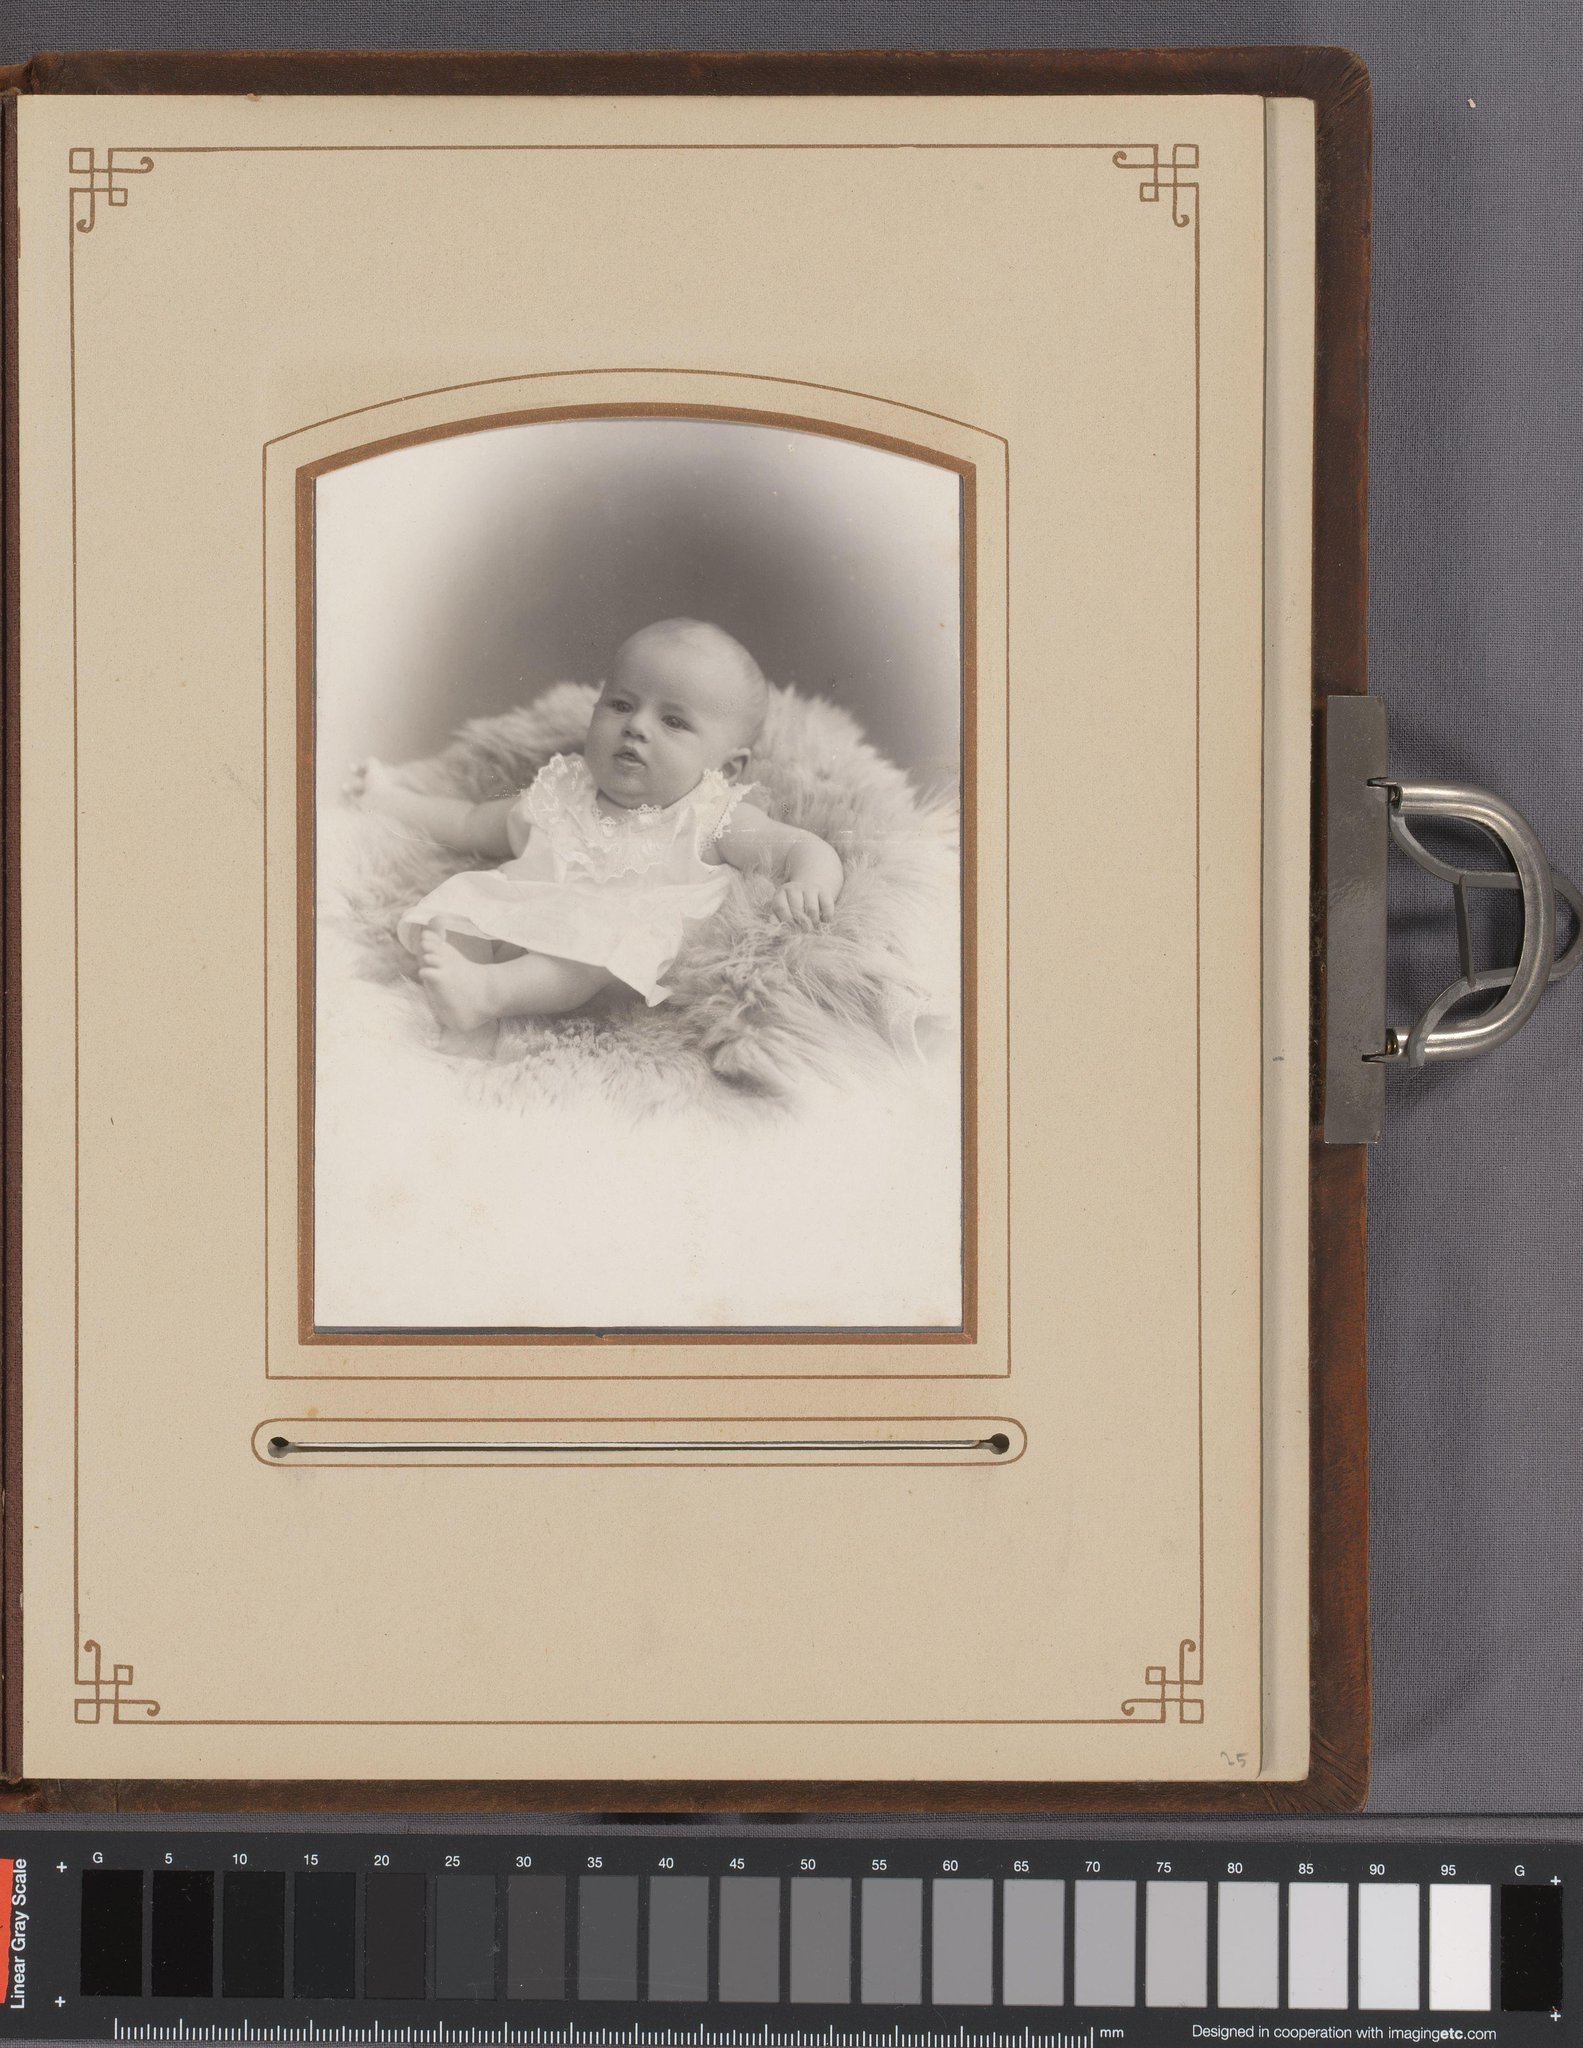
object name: photograph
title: Portret van een baby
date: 1890-1920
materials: cardboard, photographic support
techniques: collodion silver print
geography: cologne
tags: infant, baby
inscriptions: inscription: ‘Samson & Co./ Photogr. Atelier/ Köln a. Rh./ Hohestr. 53’, number: ‘3632’